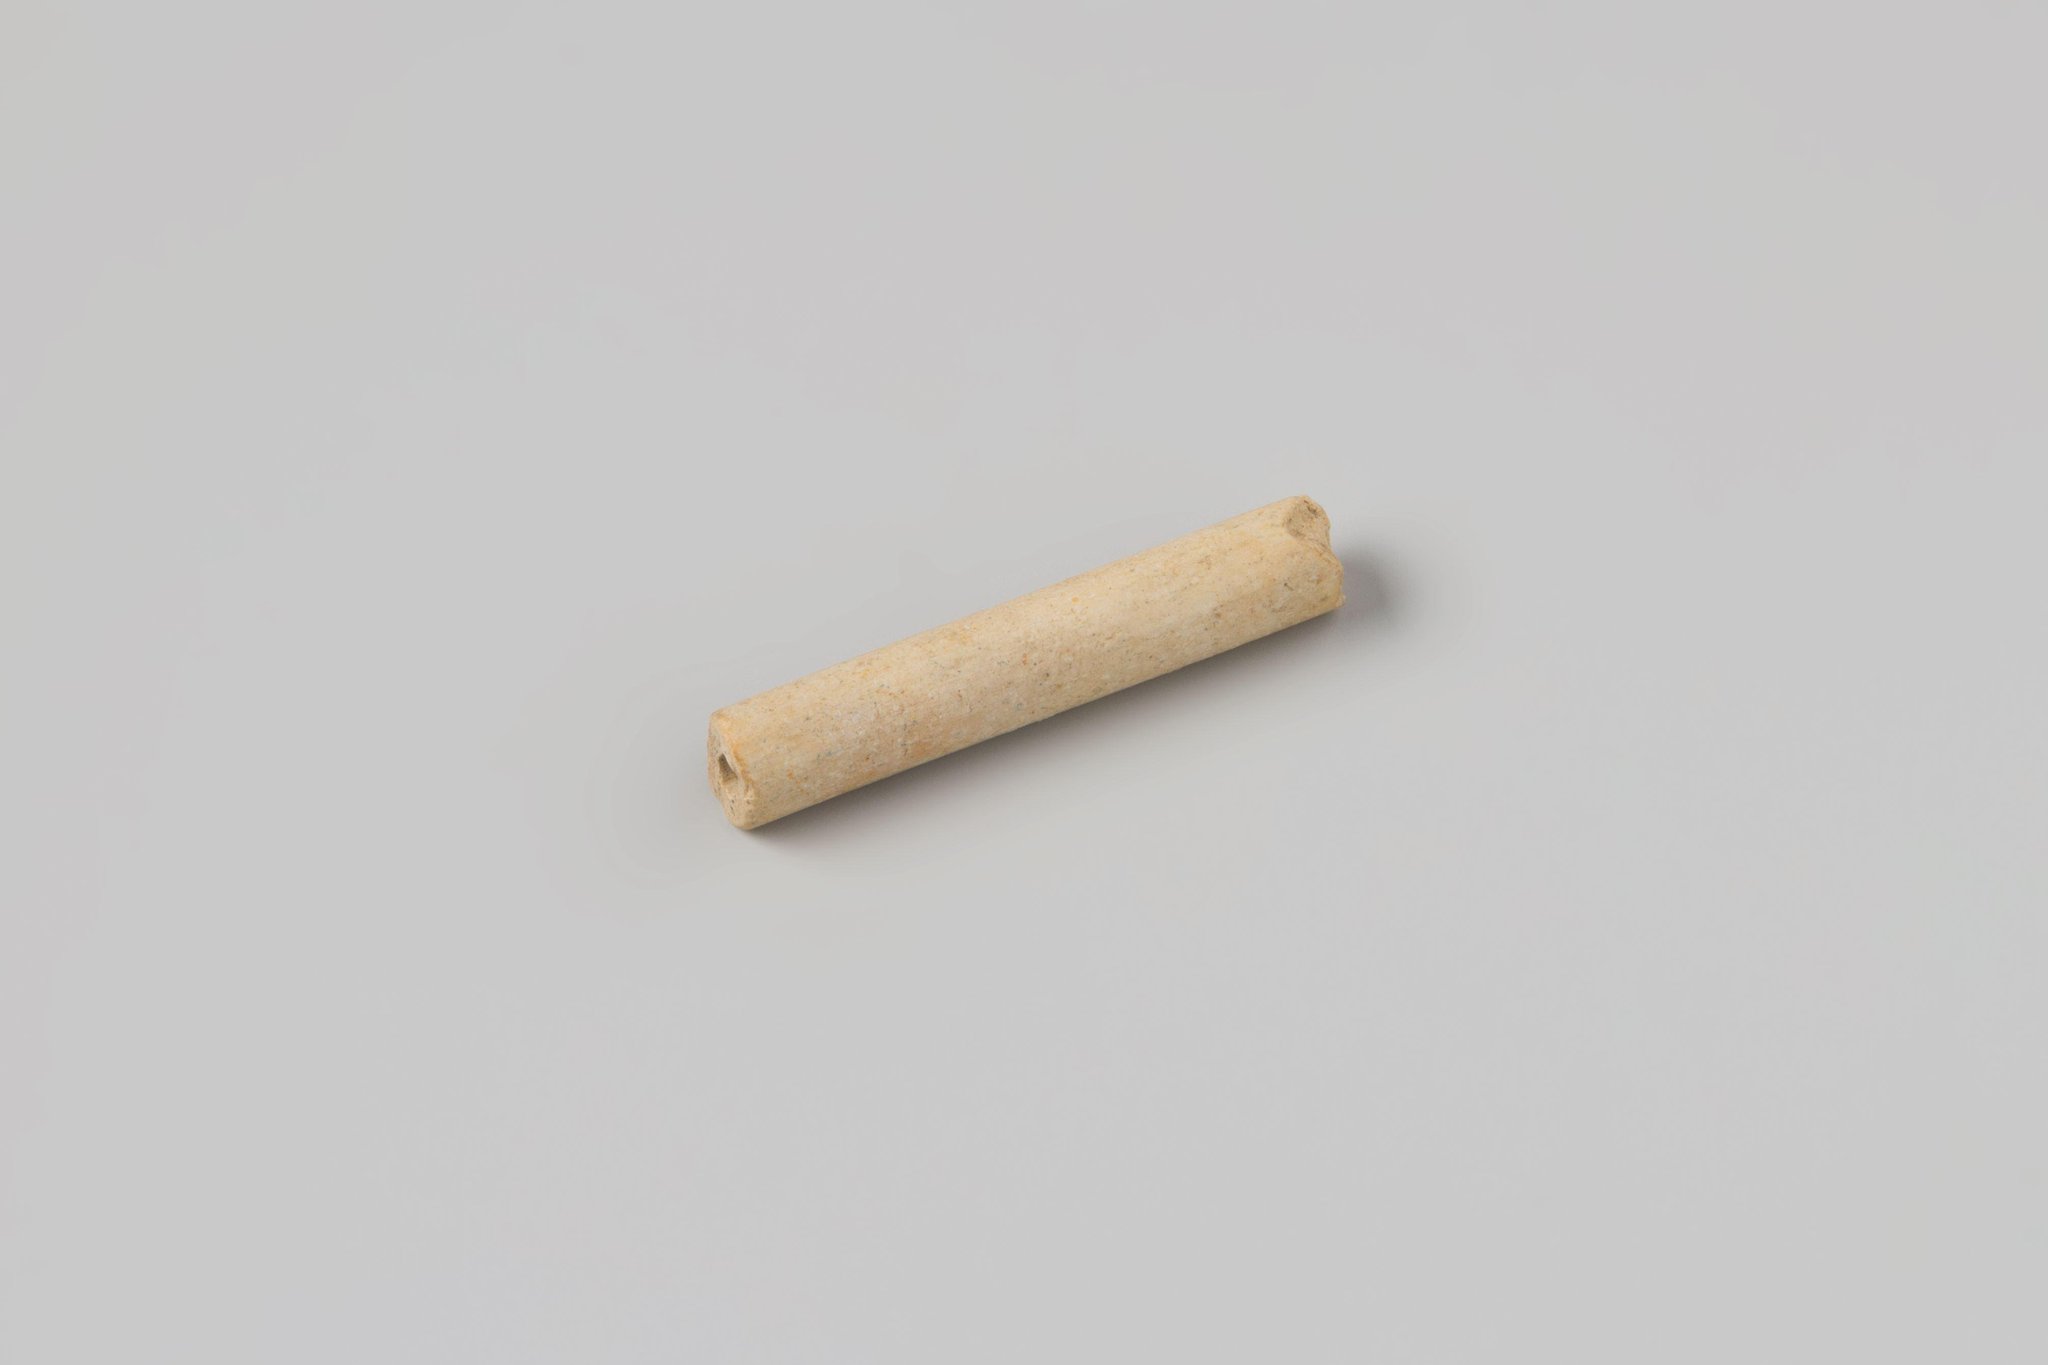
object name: pipe stem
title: Fragment pijpensteel uit het wrak van de Oost-Indiëvaarder Hollandia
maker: Anonymous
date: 1700-1743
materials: clay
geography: netherlands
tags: verenigde oostindische compagnie, hollandia (schip), annet